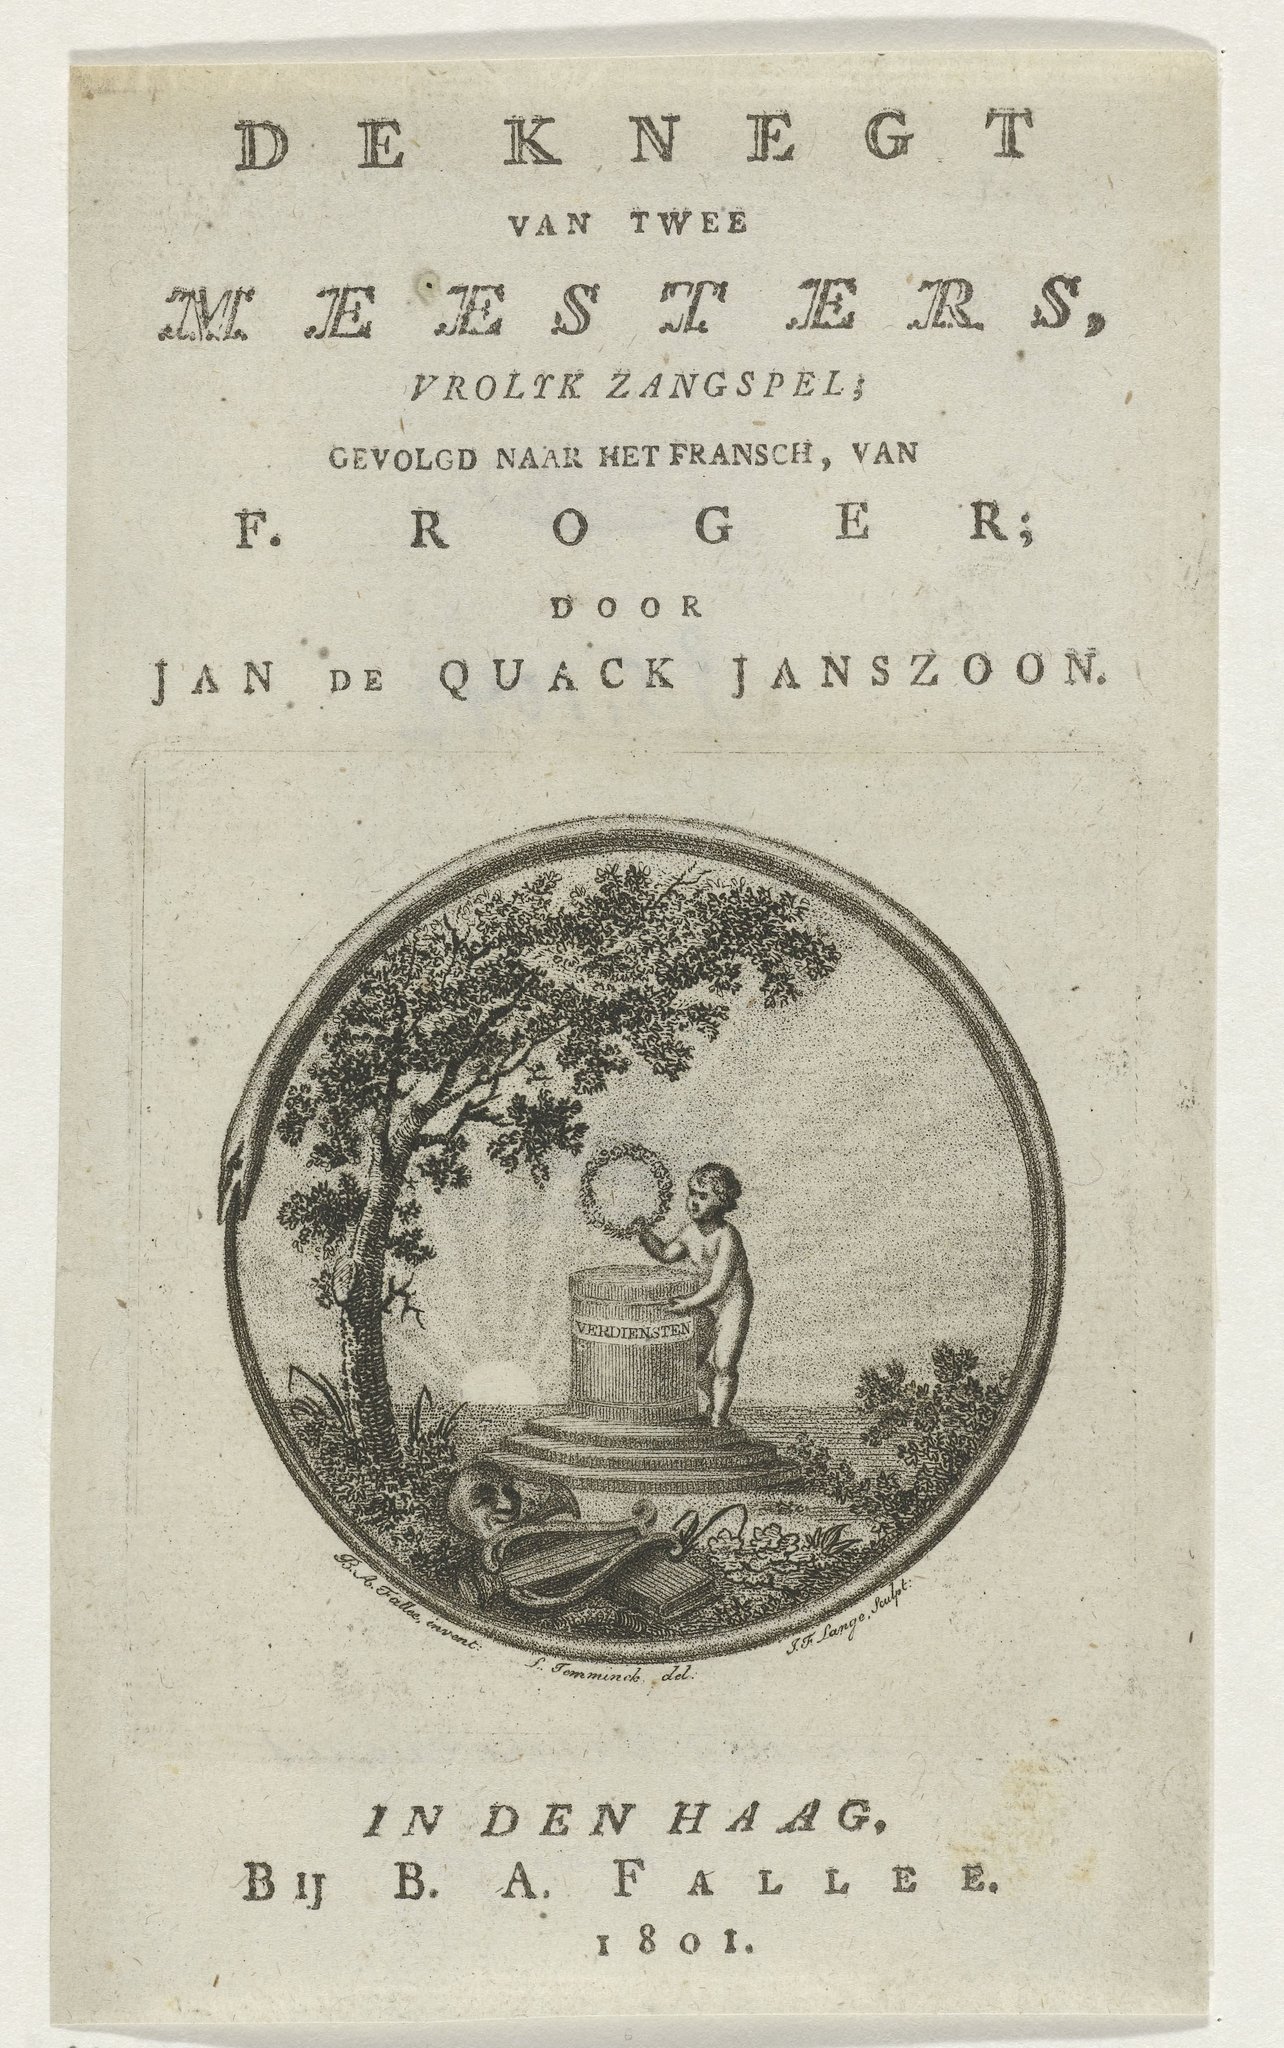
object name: print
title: Putto bij een offerzuil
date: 1801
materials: paper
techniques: etching, letterpress printing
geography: the hague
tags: crowning with laurel (+ variant), serpent ouroboros, cupids: 'amores', 'amoretti', 'putti'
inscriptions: collector's mark: Lugt 2228, collector's mark: Lugt 2760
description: Een putto staat met een lauwerkrans naast een offerzuil, op de voorgrond liggen een masker, lier en een boek. Het ronde kader van de voorstelling wordt gevormd door de Ouroboros: de slang die zich in eigen staart bijt.